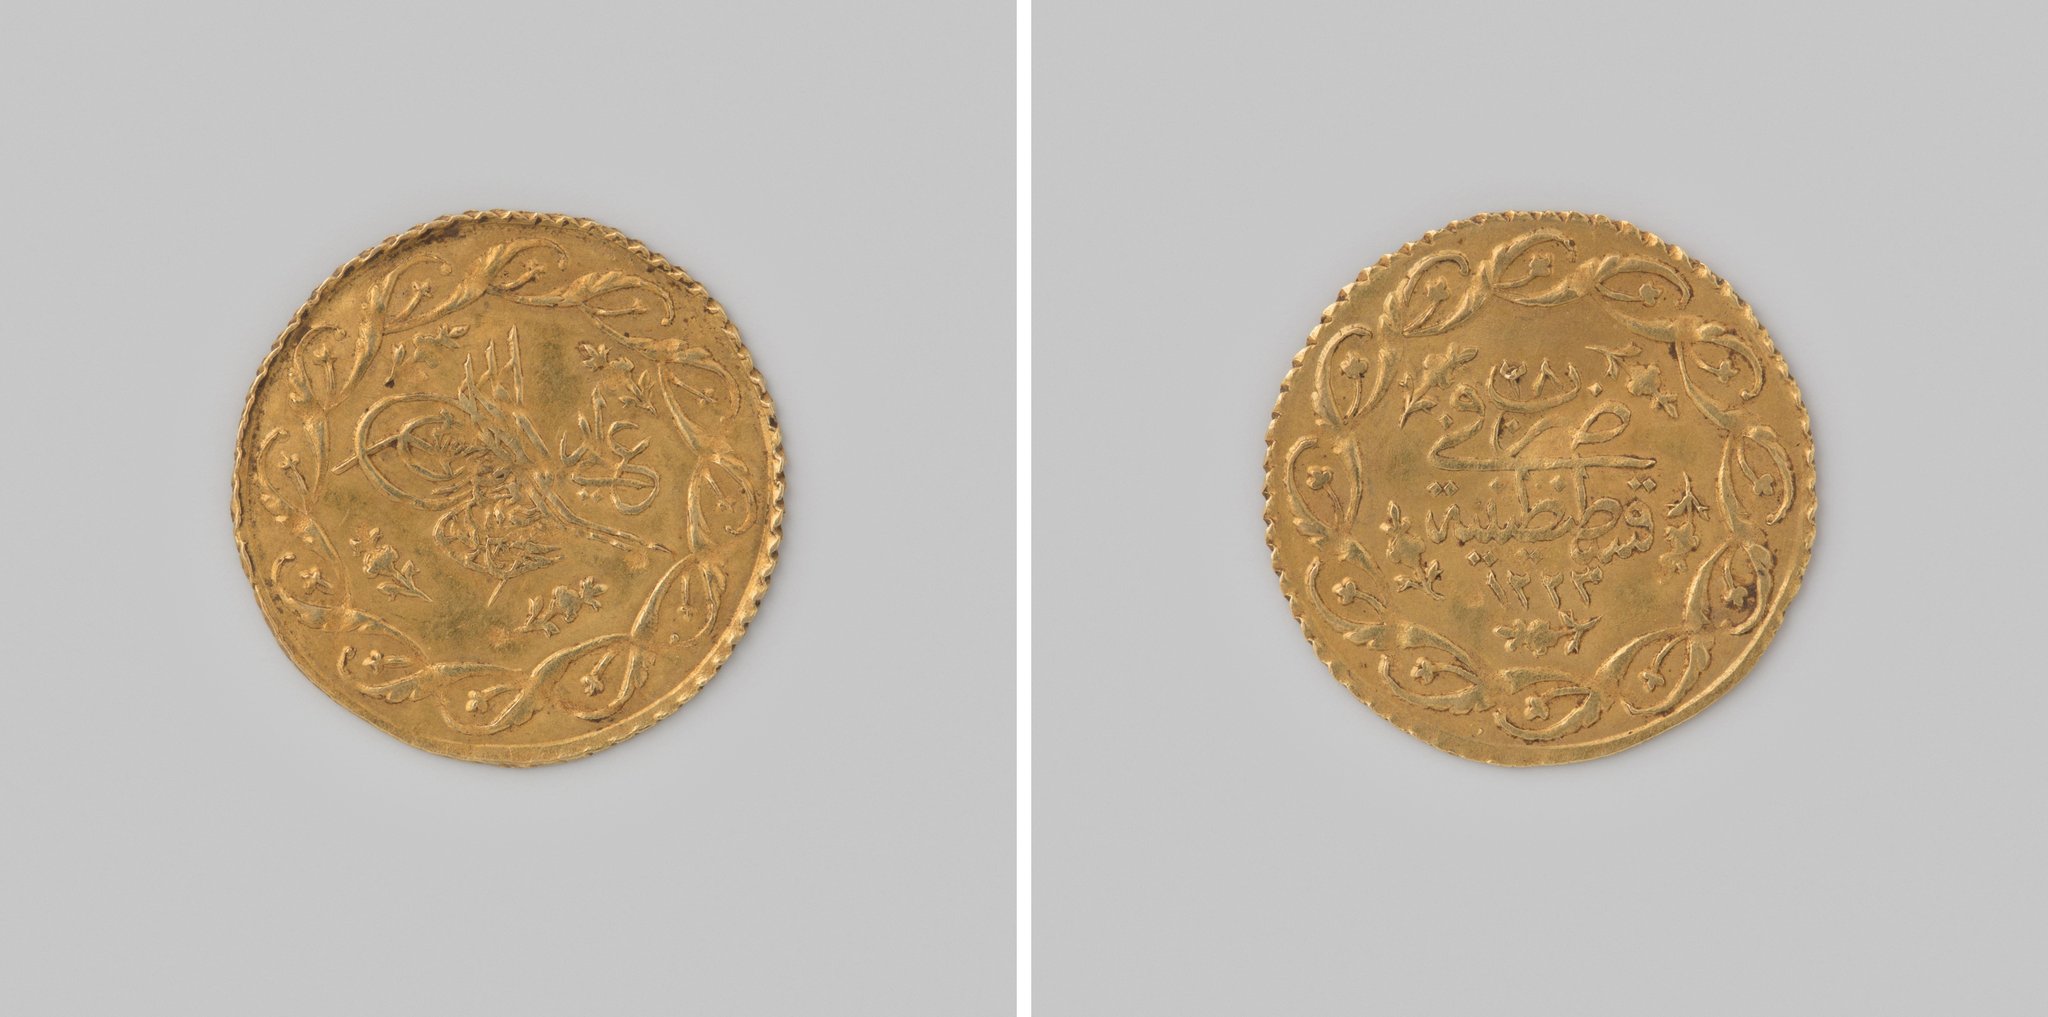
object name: coin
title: Cedid mahmudiye uit Turkije van sultan Mahmud II, regeringsjaar 27 [=1833]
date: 1833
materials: gold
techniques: striking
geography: constantinople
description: Gouden munt. Voorzijde: binnen omschrift in Arabische letters tughra met rechts daarvan opschrift: adli. Keerzijde: binnen omschrift in Arabische letters drieregelig opschrift in Arabische letters met muntplaats-aanduiding: Constantinopel. Boven in opschrift regeringsjaar: 27. Onder muntplaats-aanduiding jaar van aantreden: 1223 [=1808] met daaronder epitheton ornans van Constantinopel: al-mahrusa.